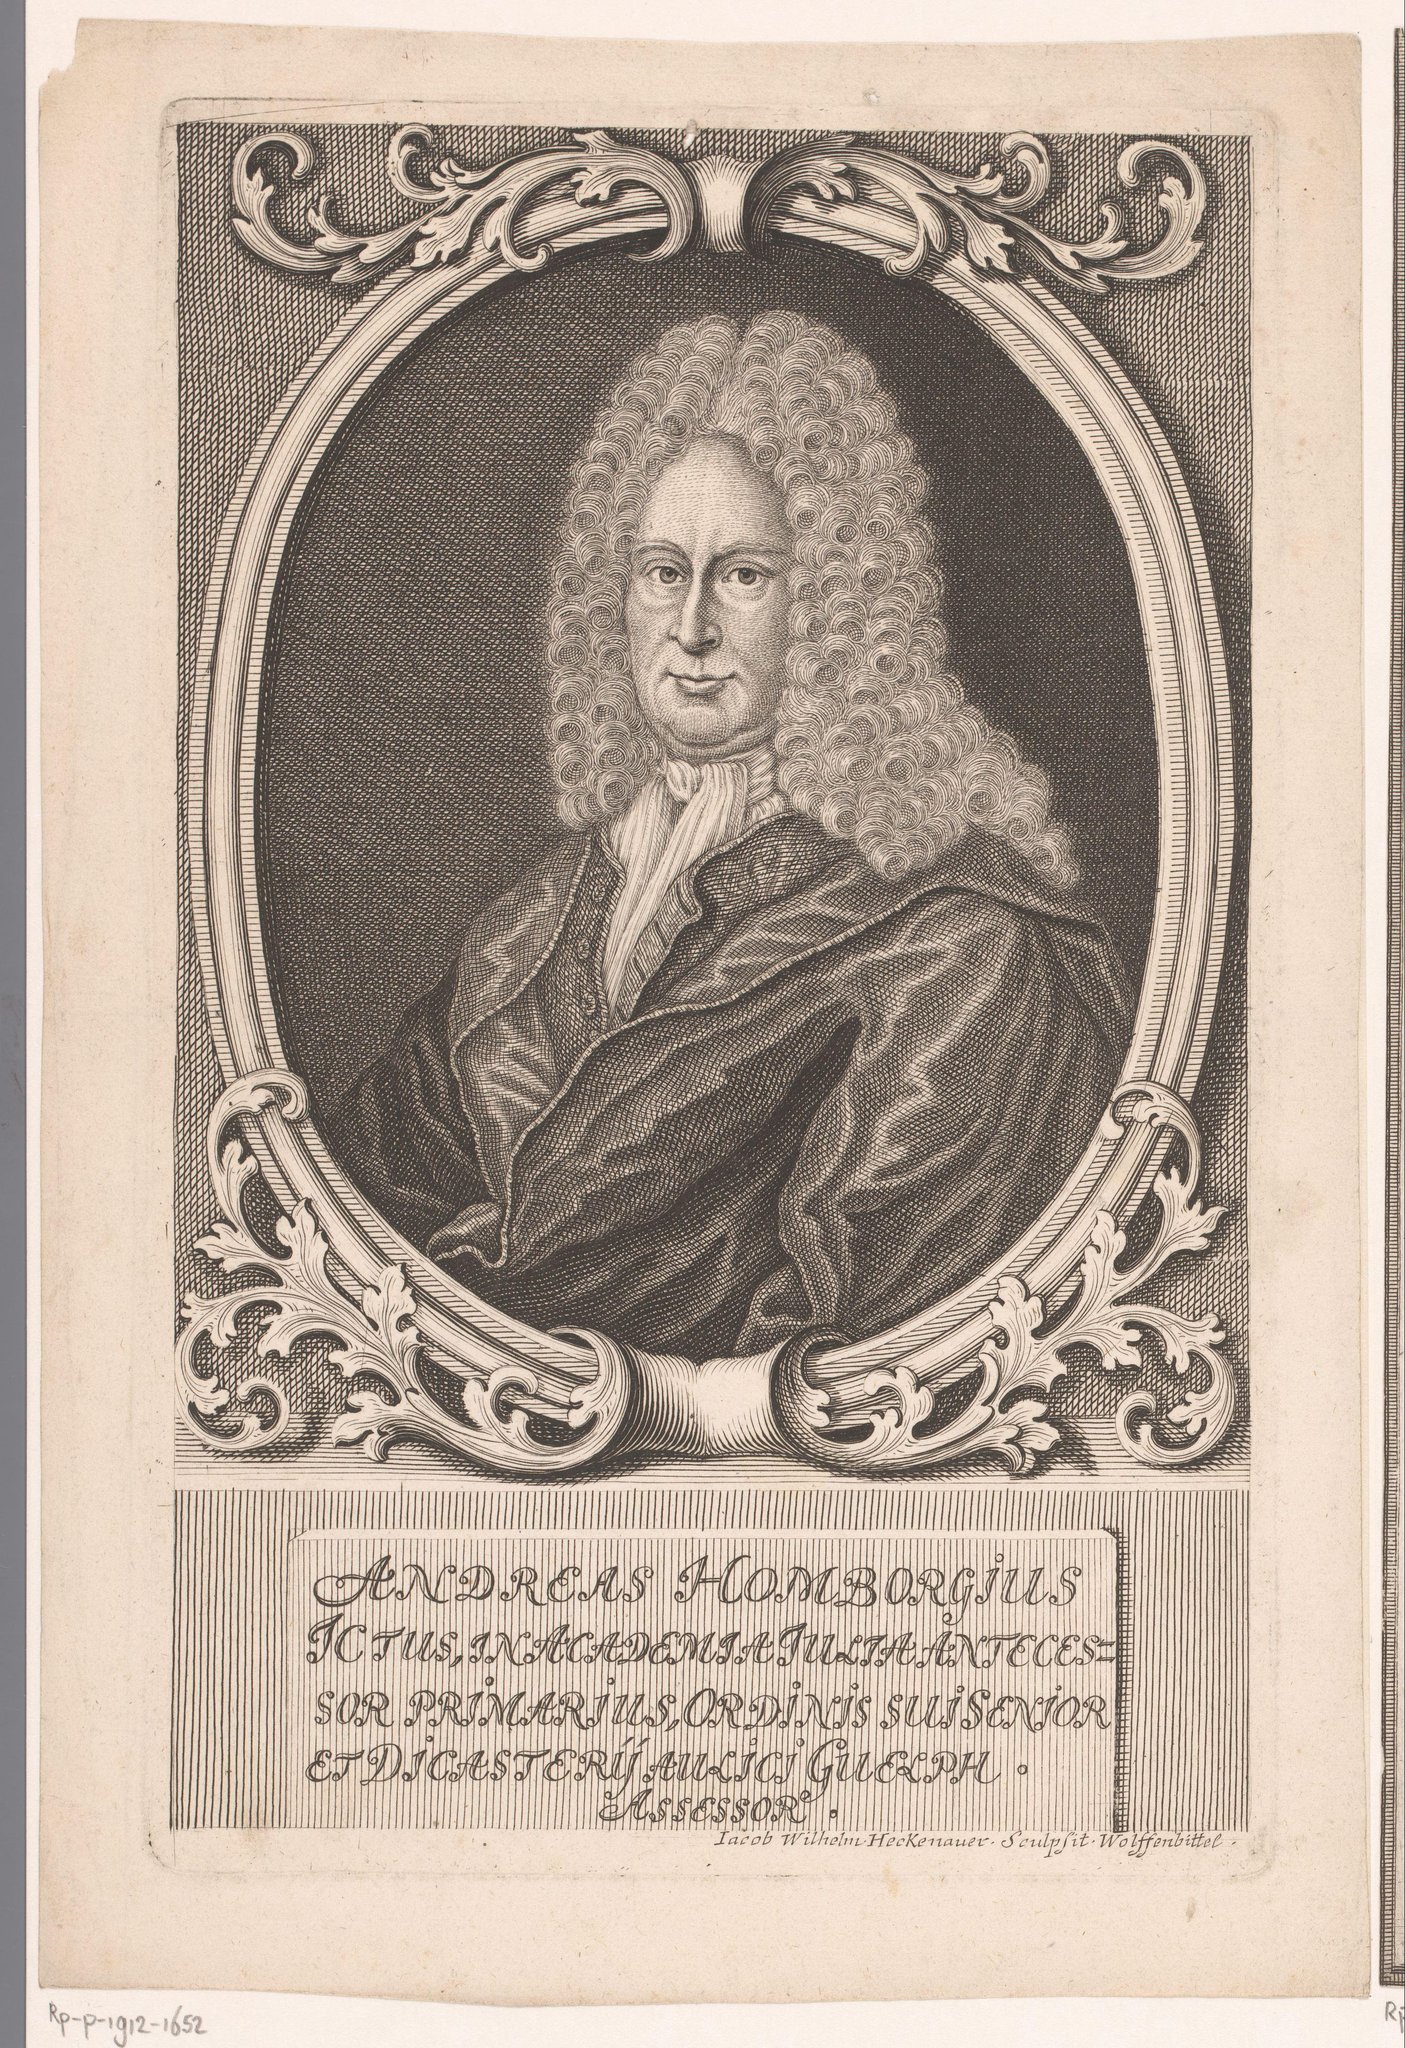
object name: print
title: Portret van Andreas Homborg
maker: jakob wilhelm heckenauer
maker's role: print maker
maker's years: 1696-1738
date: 1666-1738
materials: paper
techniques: engraving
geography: wolfenbüttel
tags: acanthus ~ ornament - aa - stylized, ornament ~ medallion, historical persons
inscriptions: collector's mark: Lugt 2228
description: Prent gebruikt voor: Homborg, Andreas. Consilia sive Responsa Helmstadiensia (...). Frankfurt am Main en Leipzig: Johann Melchior Süstermann, 1713.